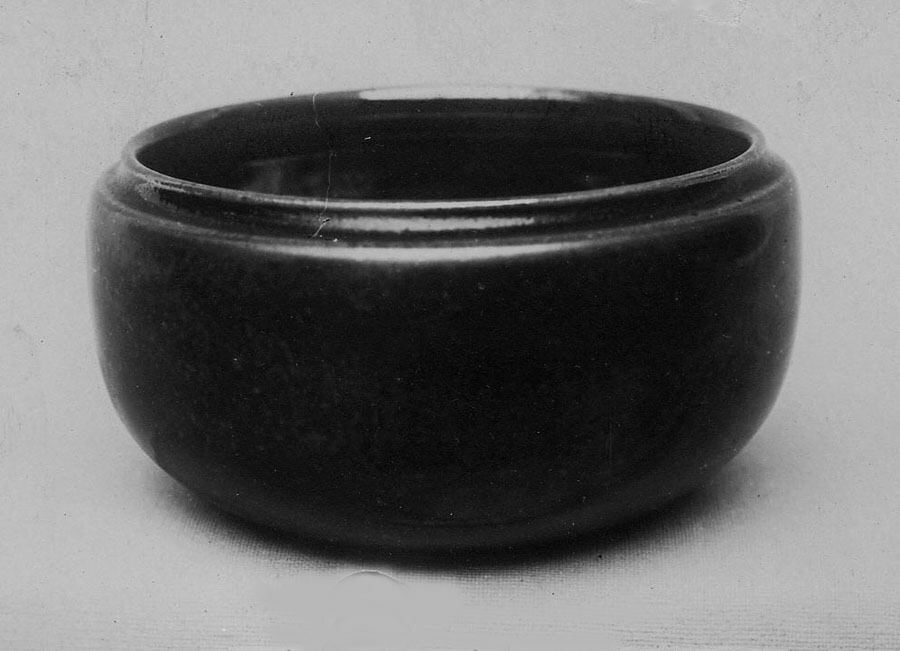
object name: tea jar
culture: japanese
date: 1700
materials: clay, glaze